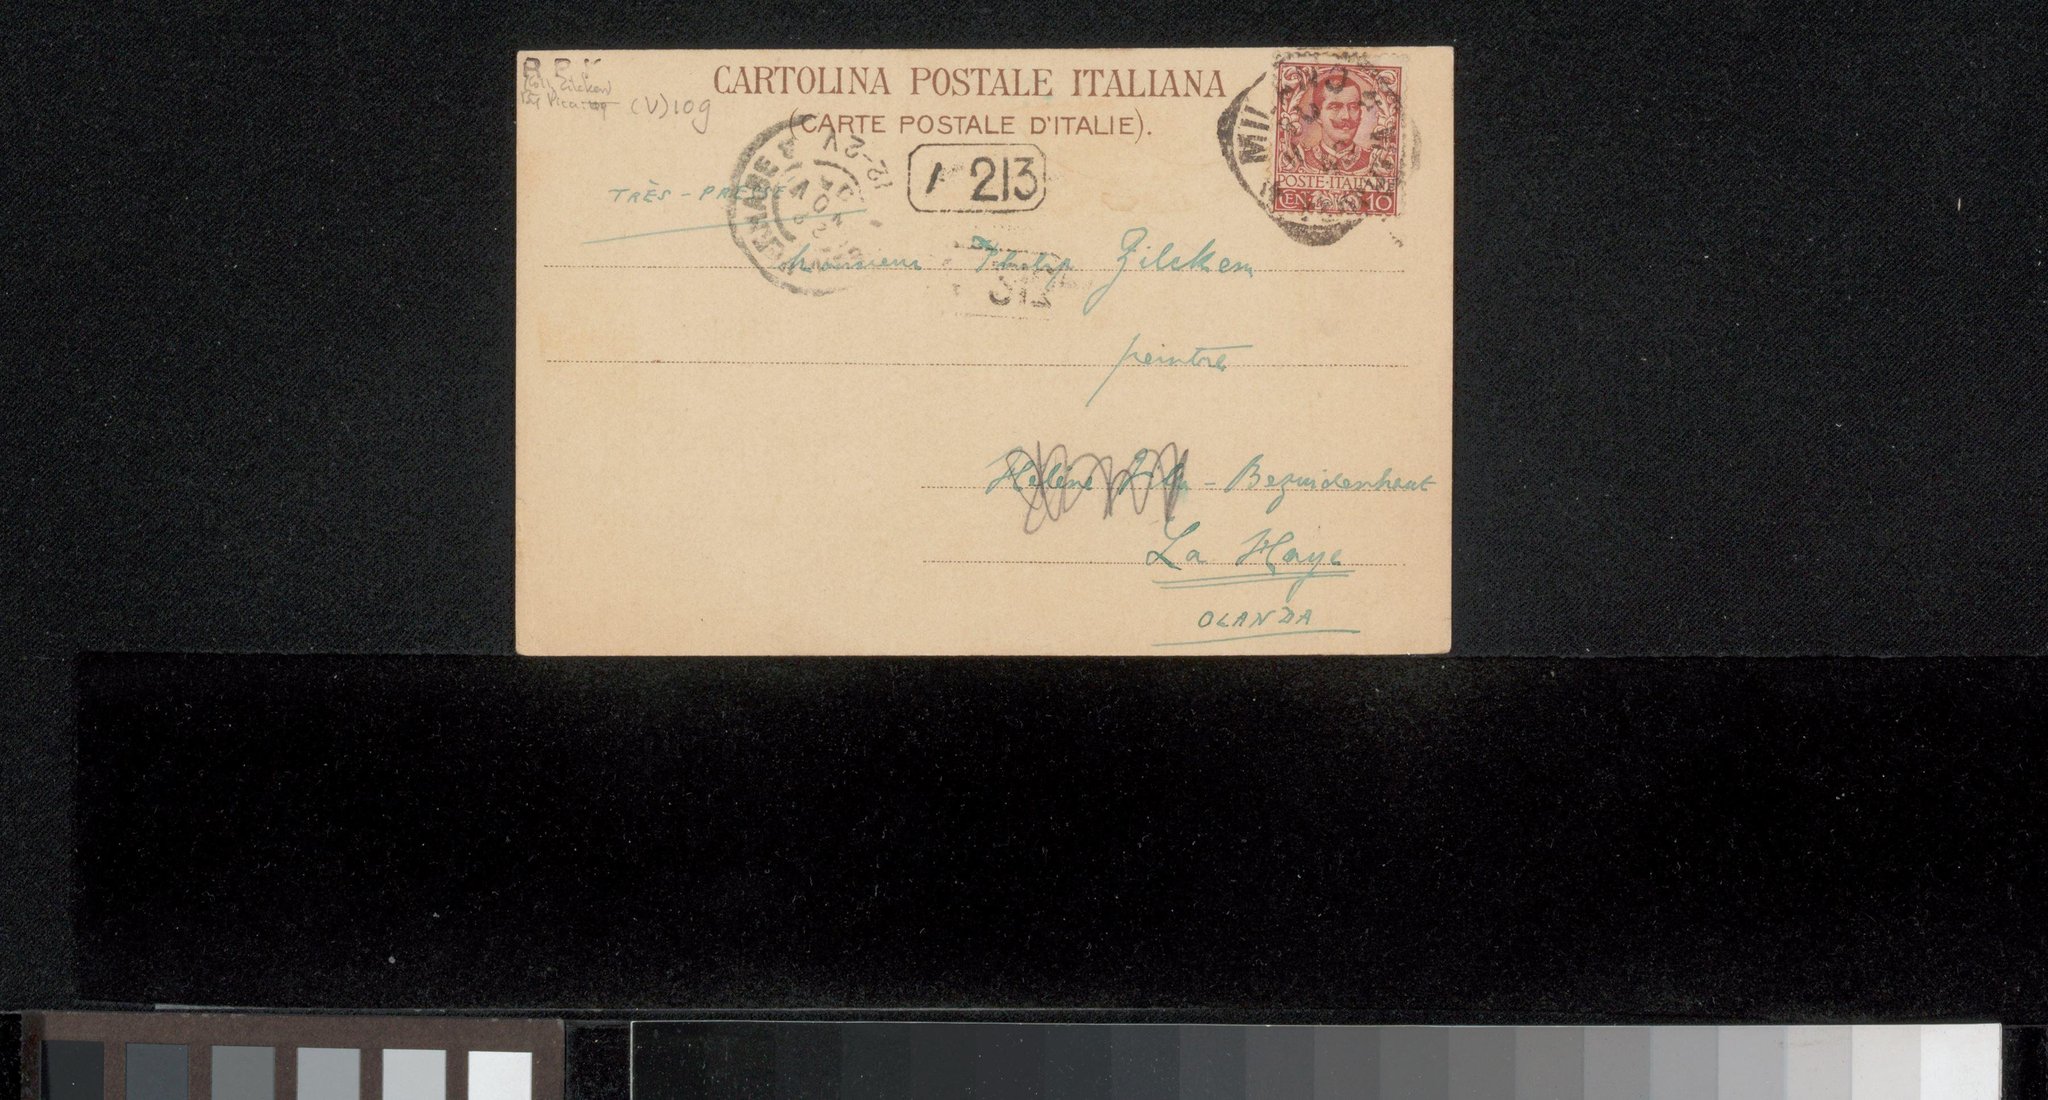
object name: postcard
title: Briefkaart aan Philip Zilcken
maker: vittorio pica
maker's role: criticus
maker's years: 1864-1930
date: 1905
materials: cardboard, ink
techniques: pen, printing, writing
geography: milan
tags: the hague, painter, print maker, draughtsman, jozef israëls, philip zilcken, exhibition ~ art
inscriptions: collector's mark: ‘RPK’